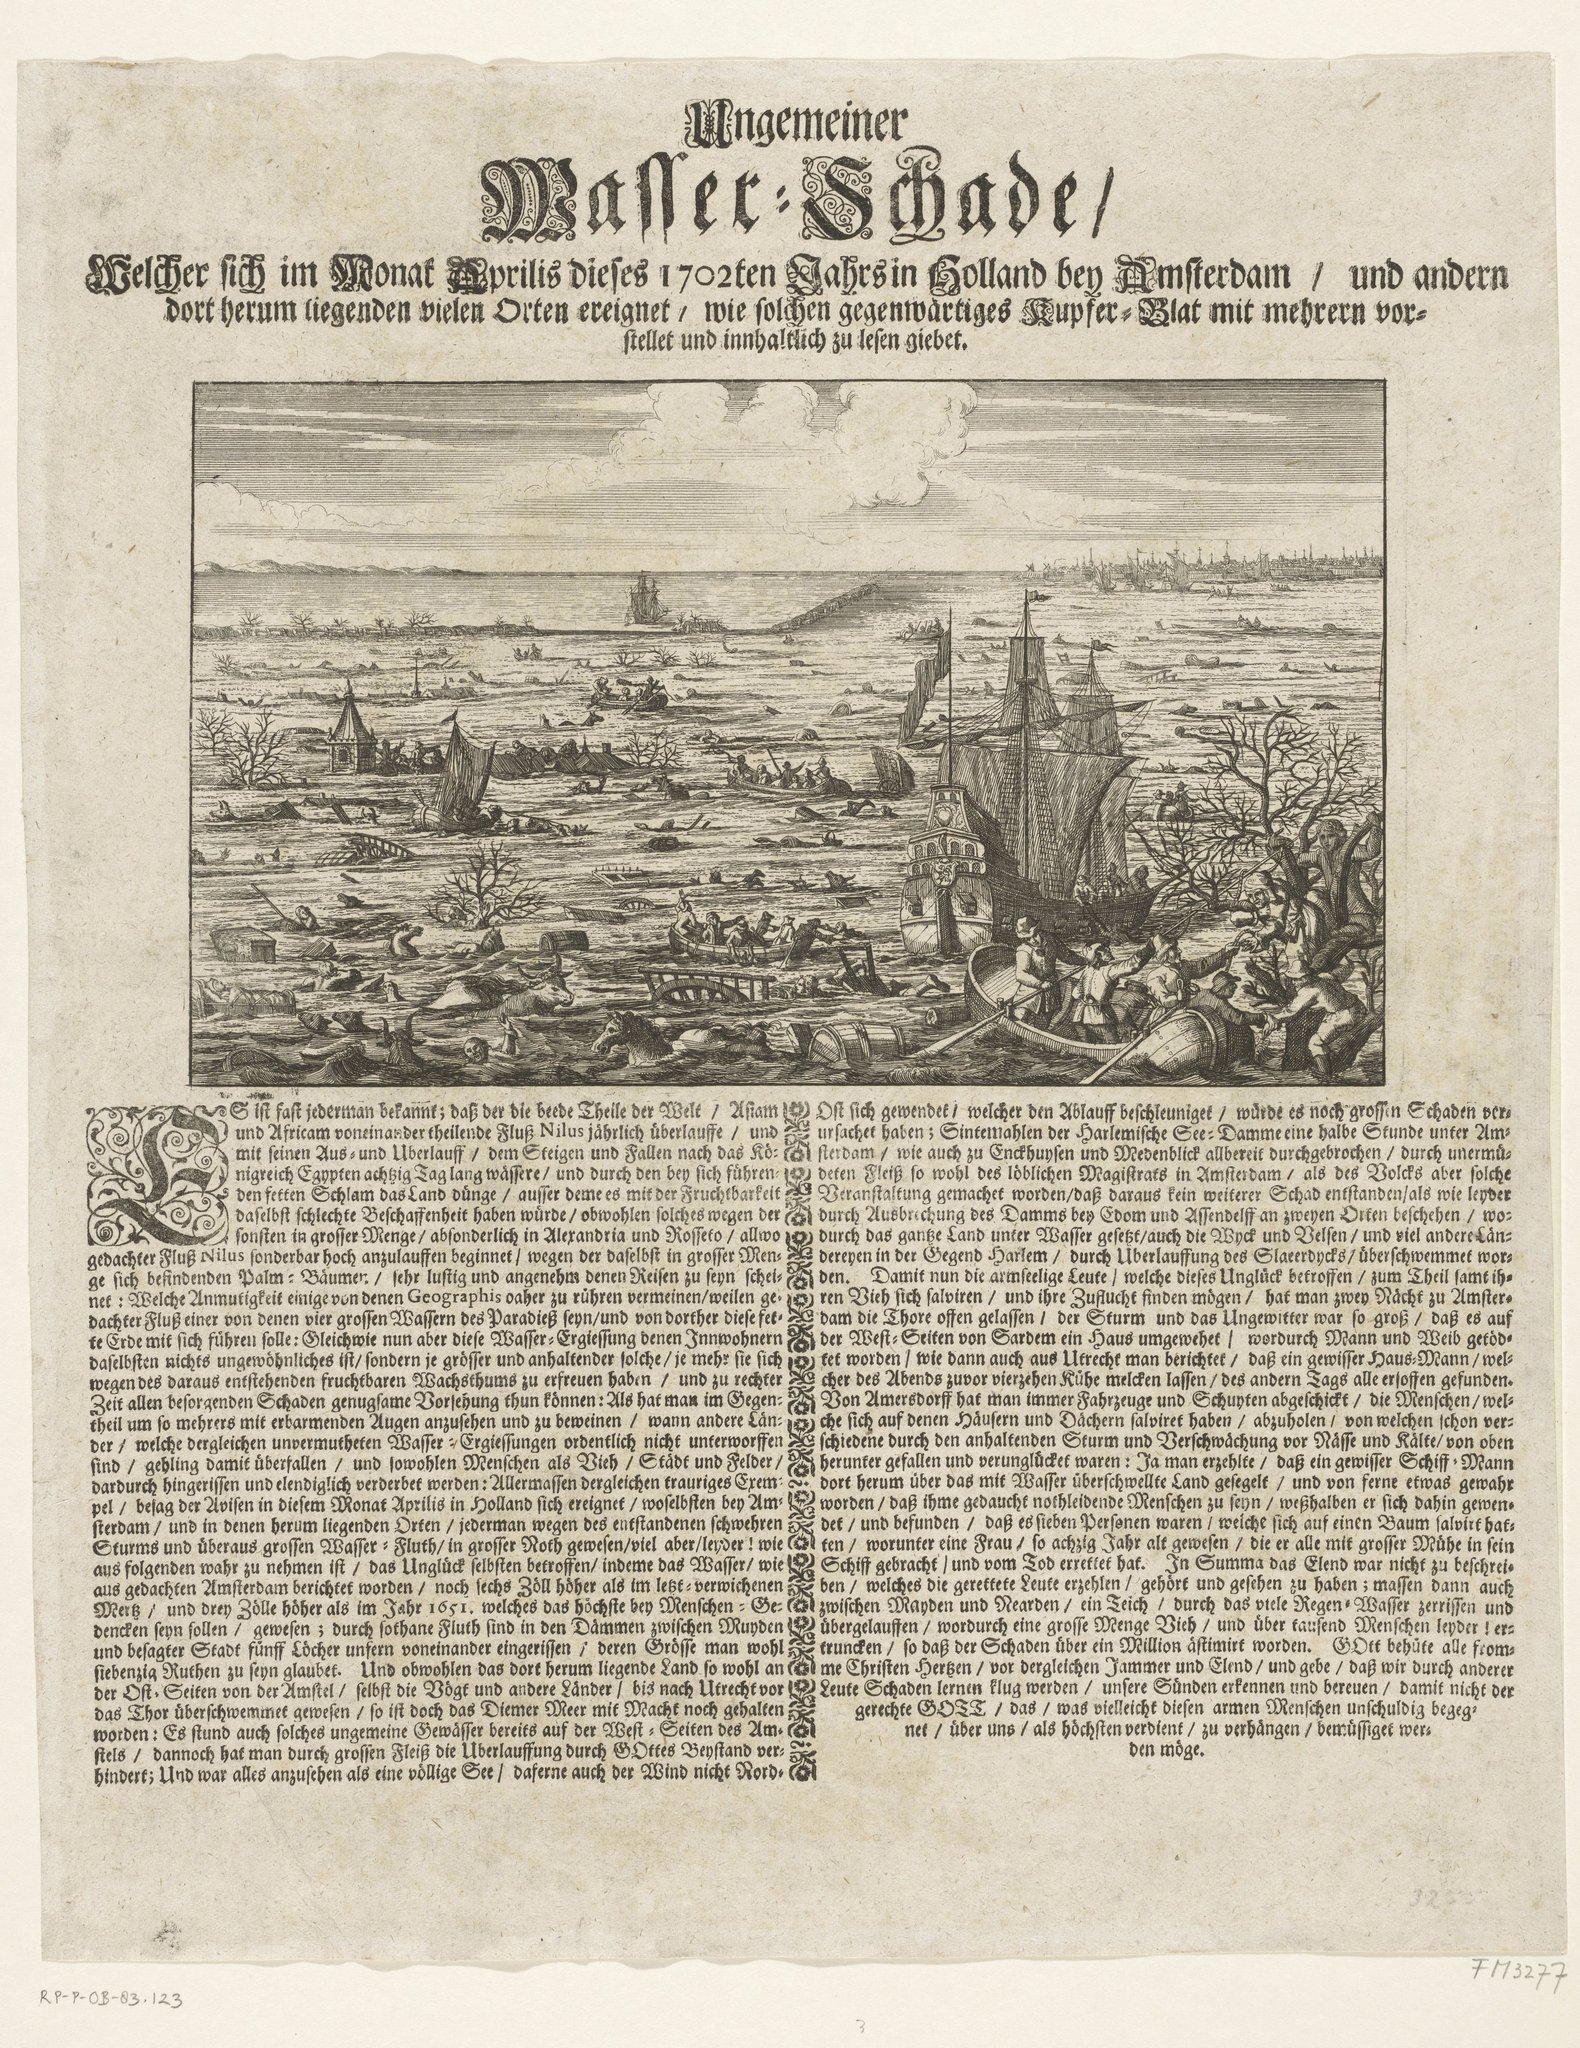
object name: print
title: Watersnood in Holland, 1702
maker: Anonymous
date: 1702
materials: paper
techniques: etching, letterpress printing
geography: germany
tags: dike-break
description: Watersnood in Holland, 5 en 6 april 1702. Een schip en boten varen door het overstroomde gebied en pikken overlevenden op. Op het blad onder de plaat twee kolommen tekst in het Duits.